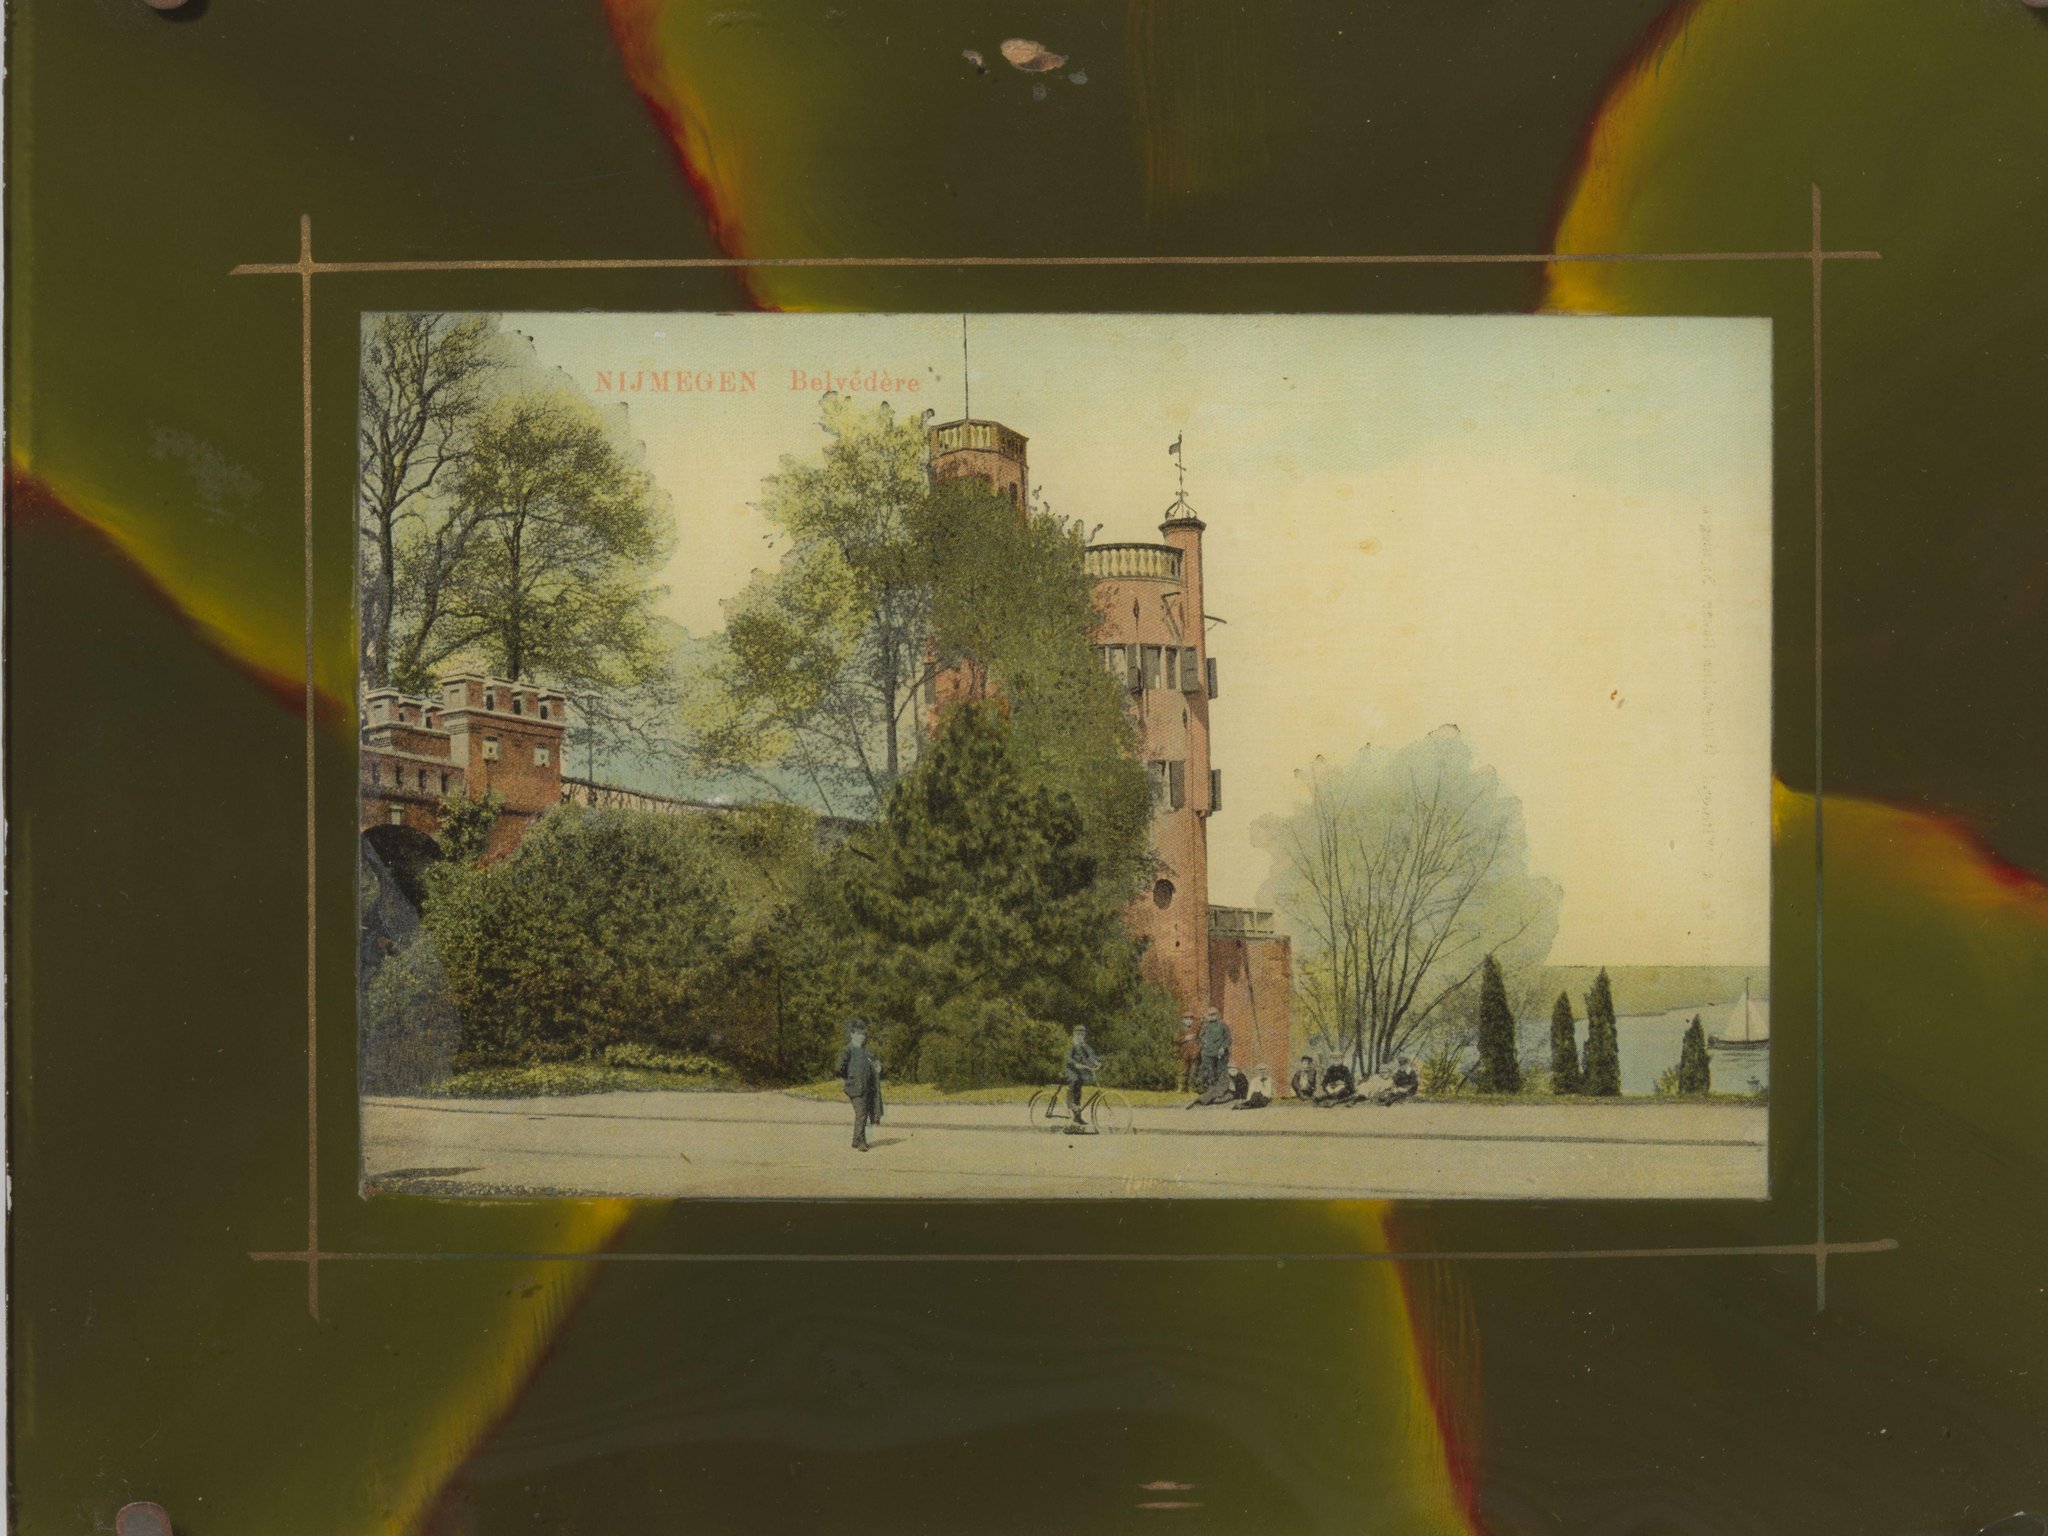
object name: frame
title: Gezicht op de Belvédère in Nijmegen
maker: Anonymous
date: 1880-1900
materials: cardboard, glass, metal, paper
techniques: lithograph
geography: nijmegen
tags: towers ~ fortified city